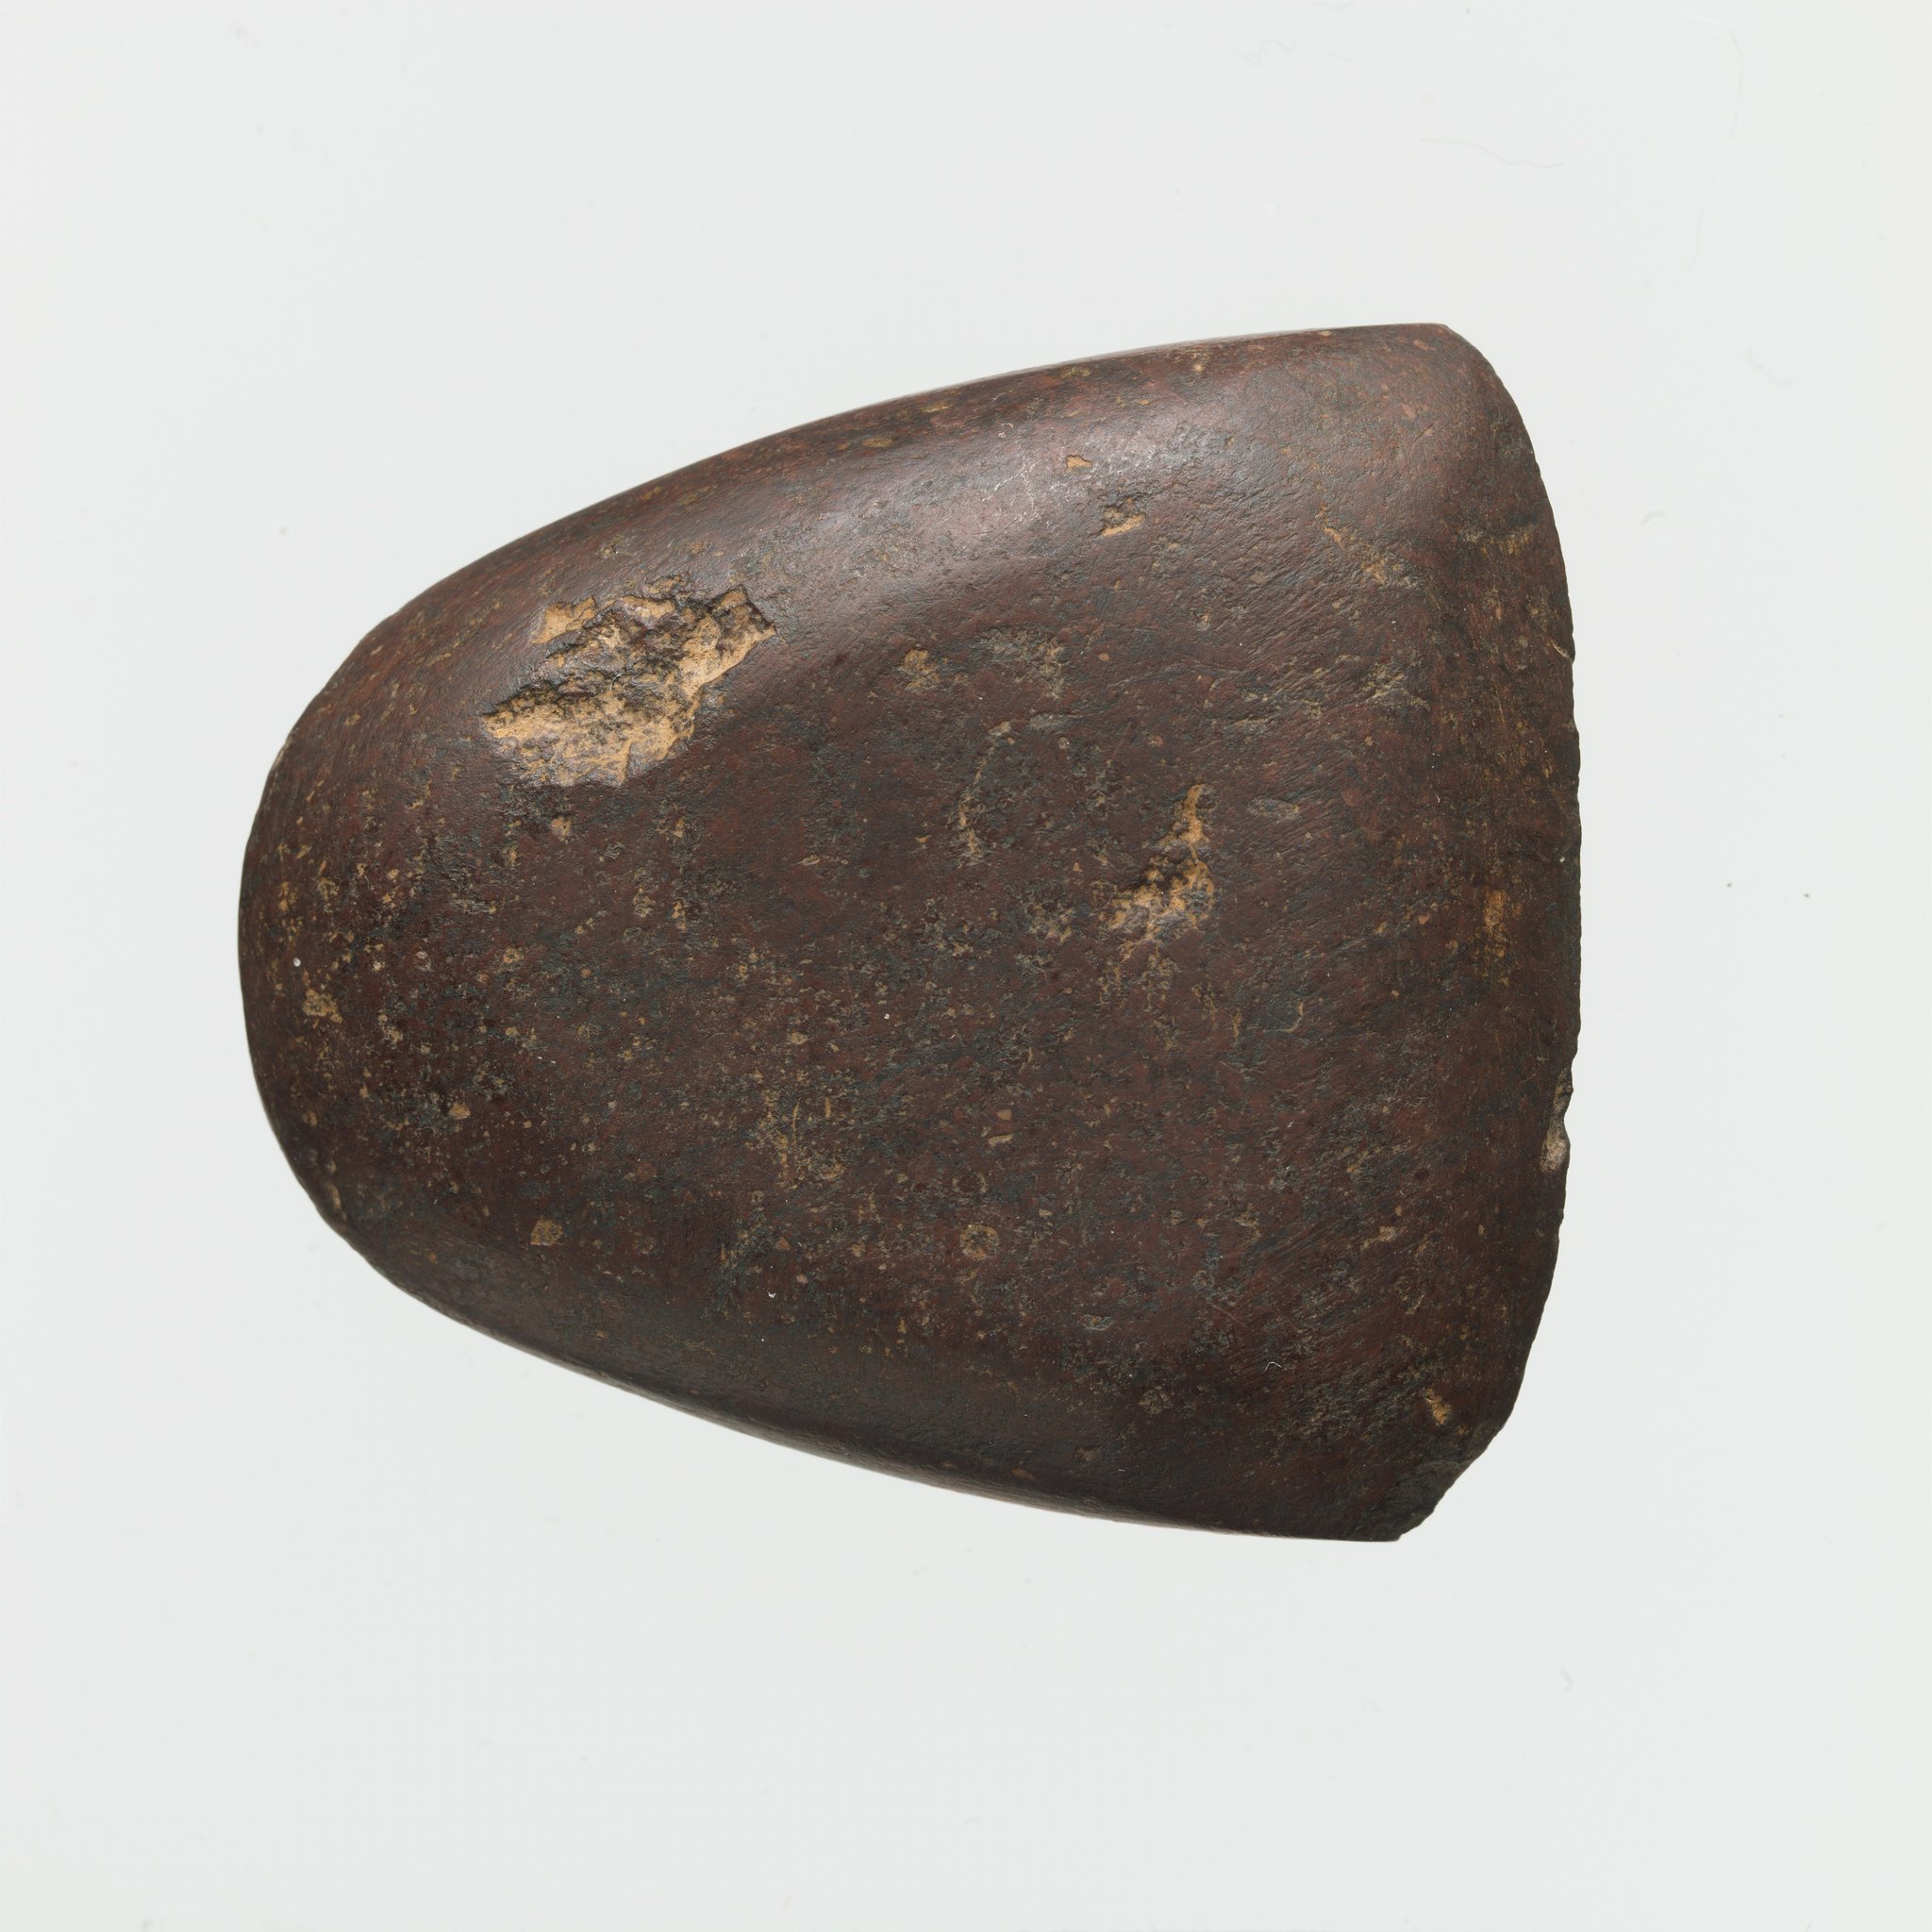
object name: celt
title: Small metabauxite axe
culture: cretan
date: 5000-3001 BCE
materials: stone